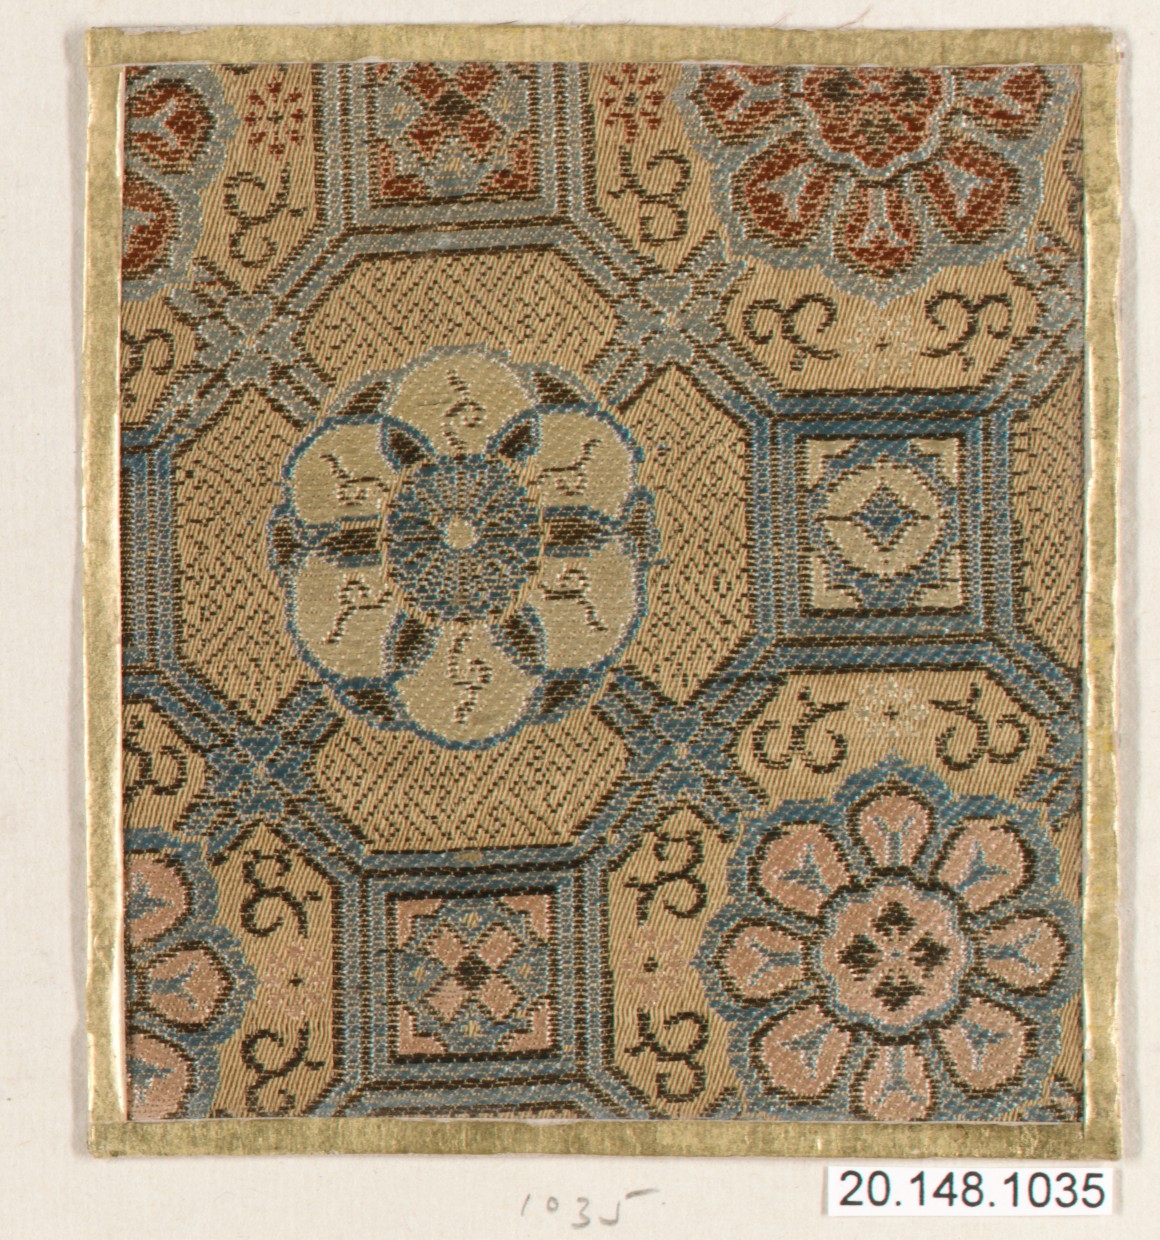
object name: piece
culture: japanese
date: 1701-1800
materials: silk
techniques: compound weave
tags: flowers